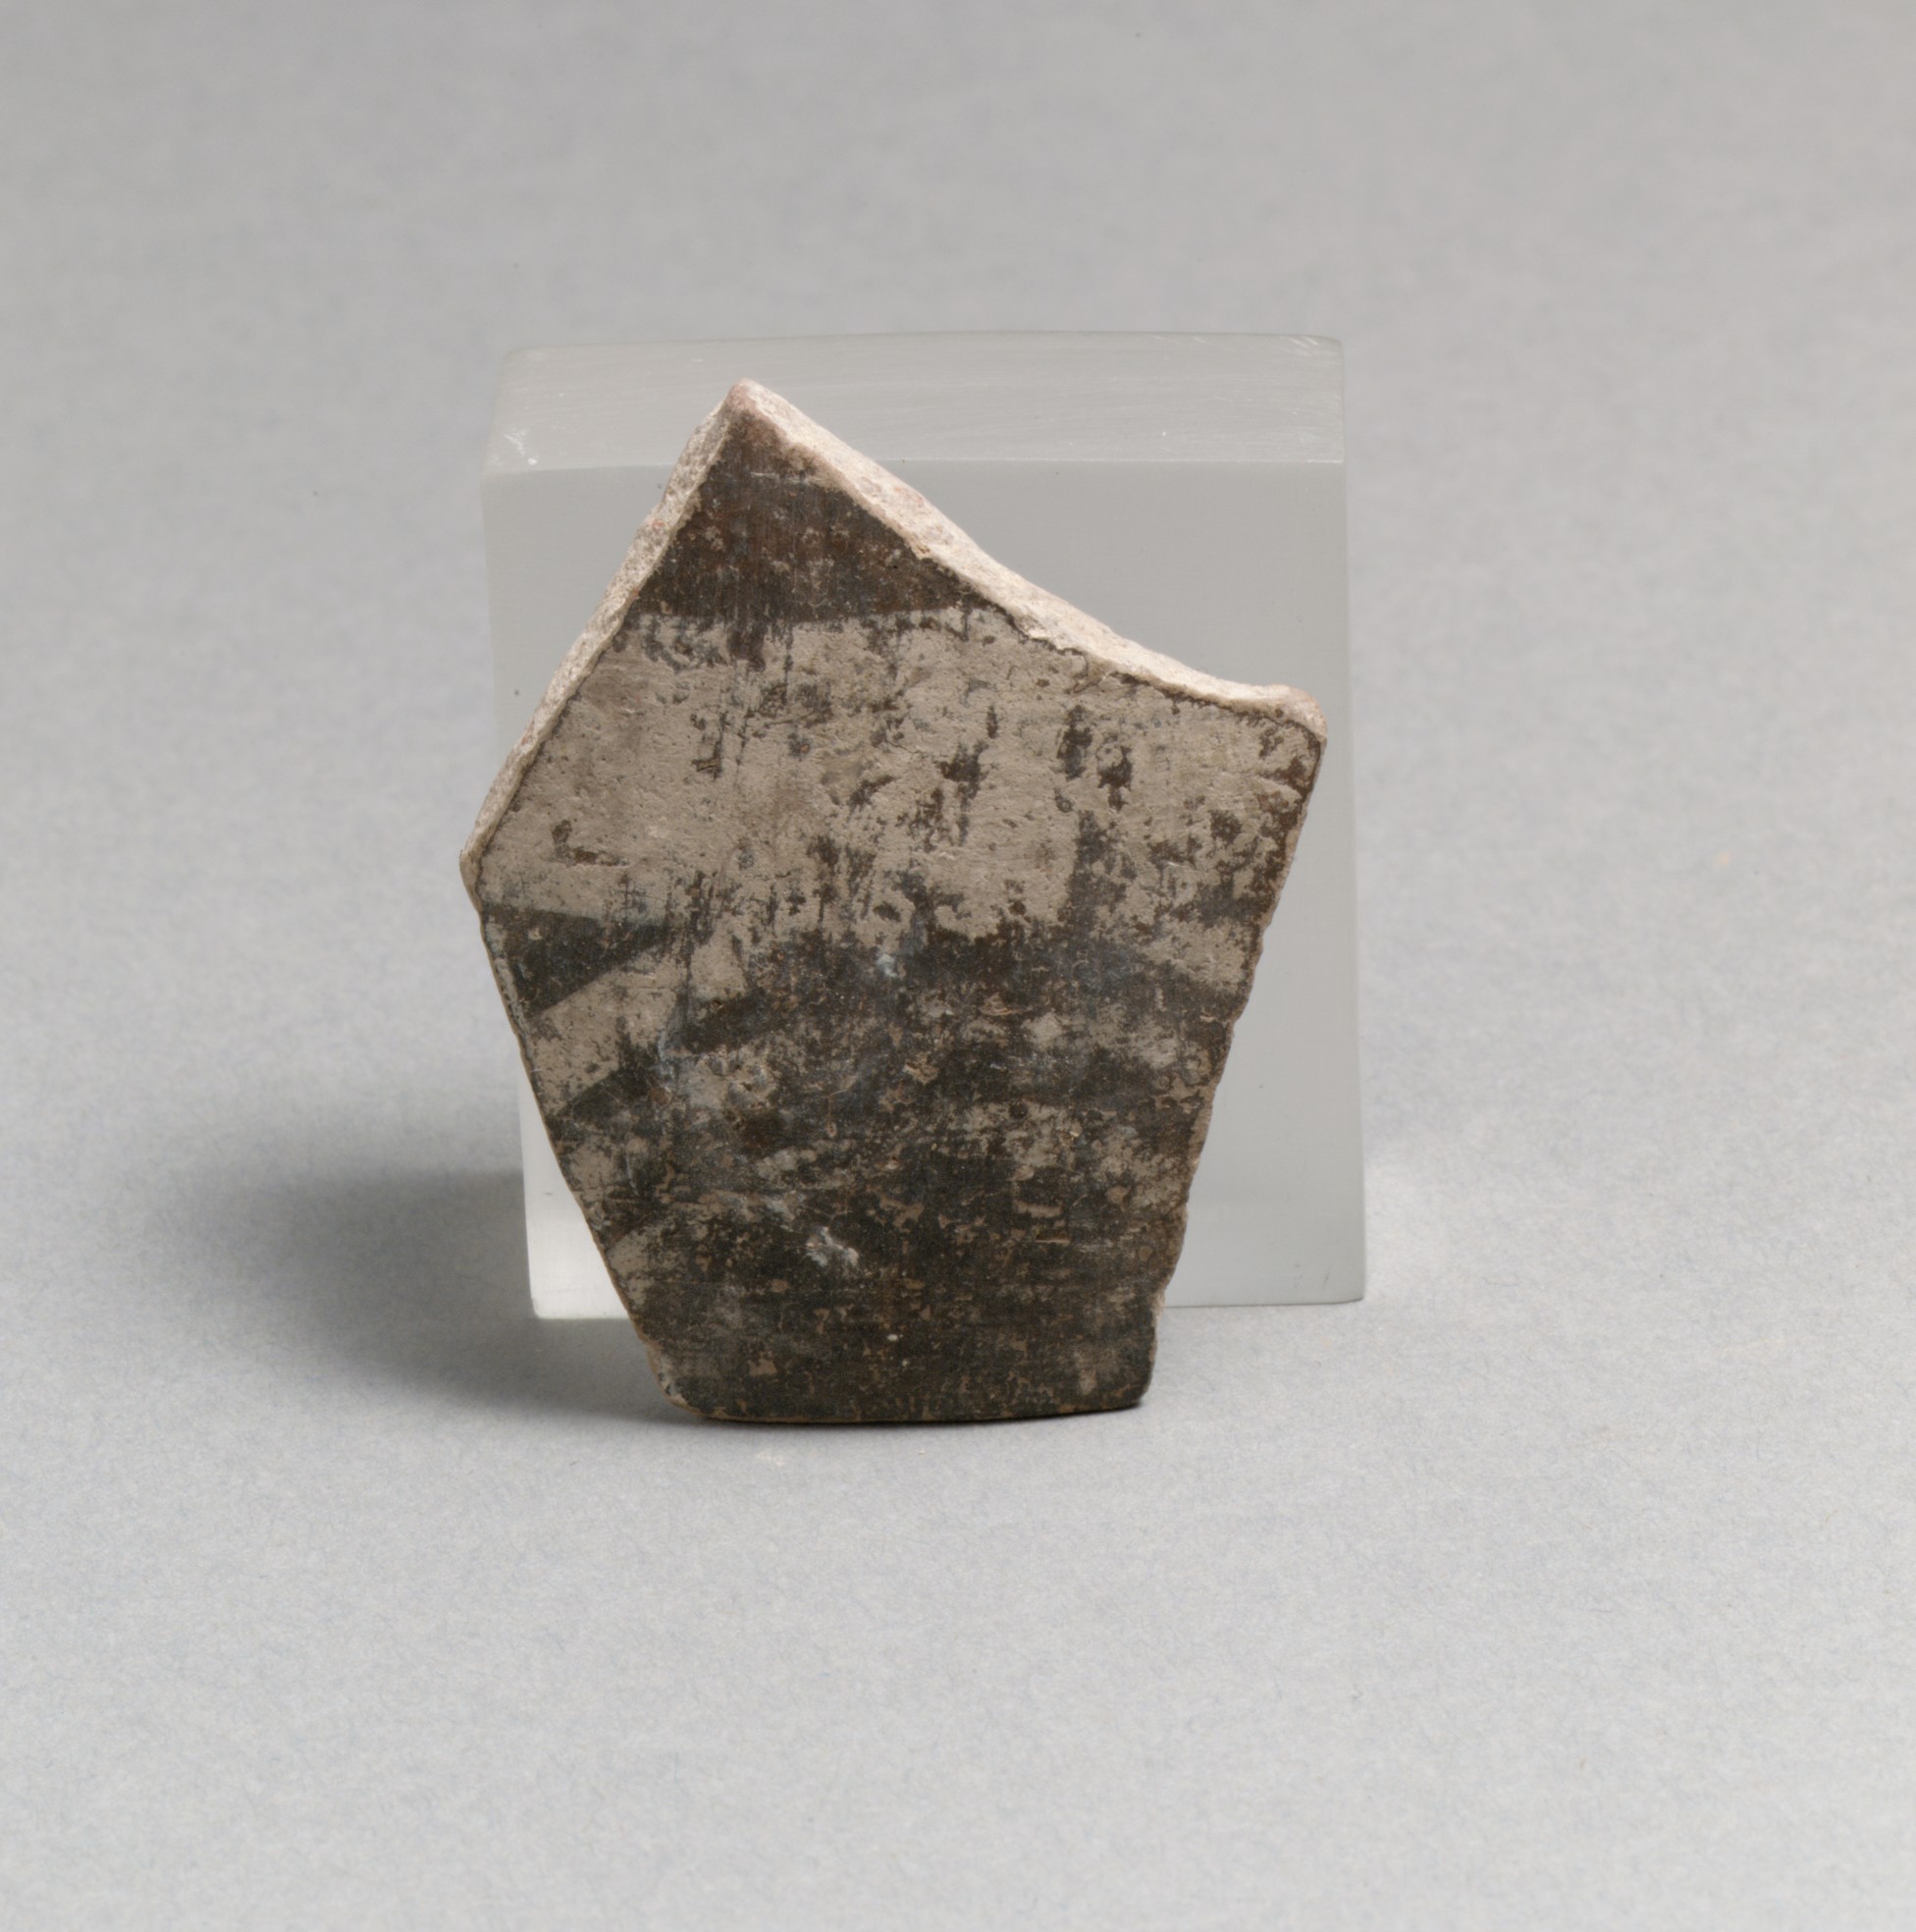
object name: vase fragment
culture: minoan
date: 2600-2000 BCE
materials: terracotta